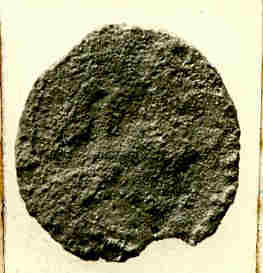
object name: coin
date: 401-1400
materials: copper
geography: iran